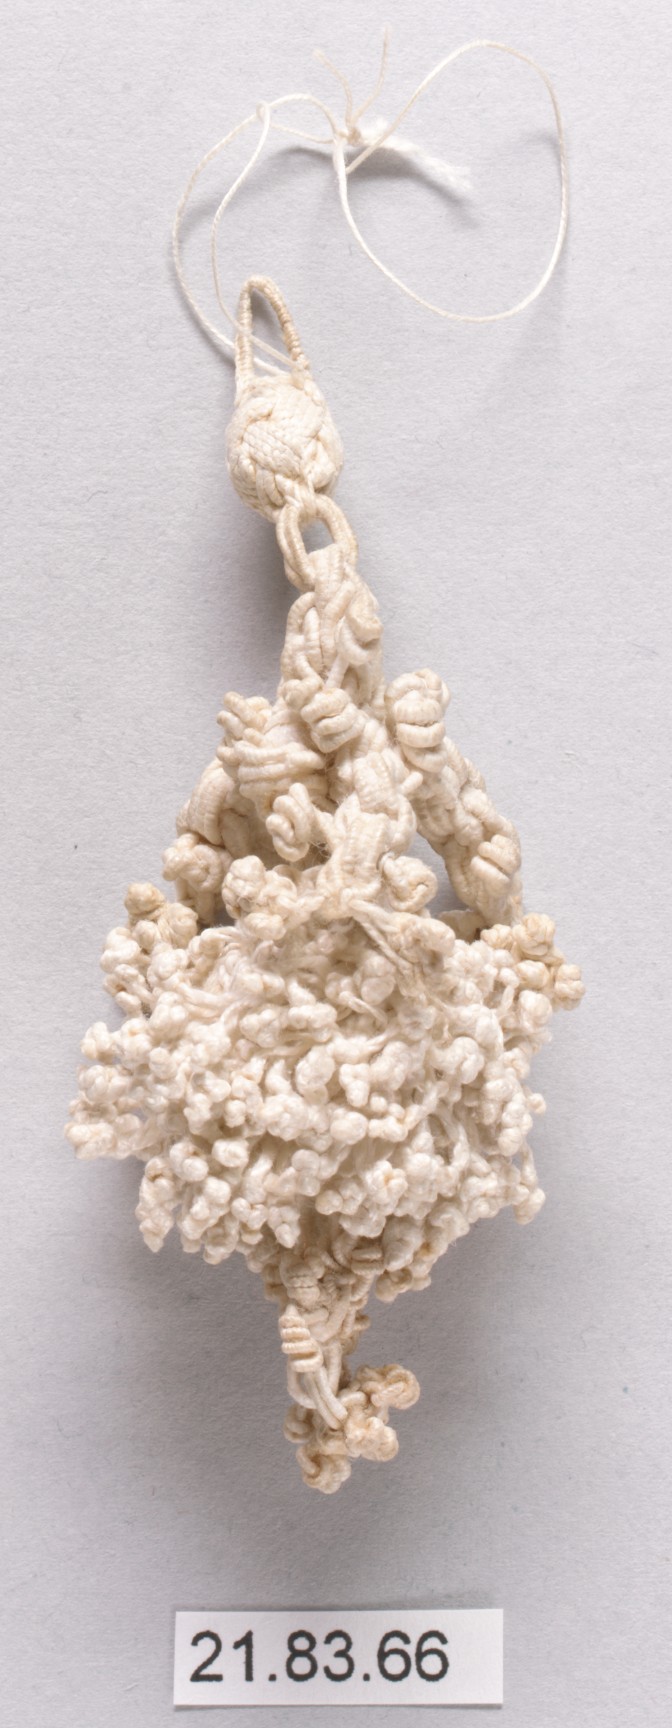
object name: tassel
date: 1601-1700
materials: linen